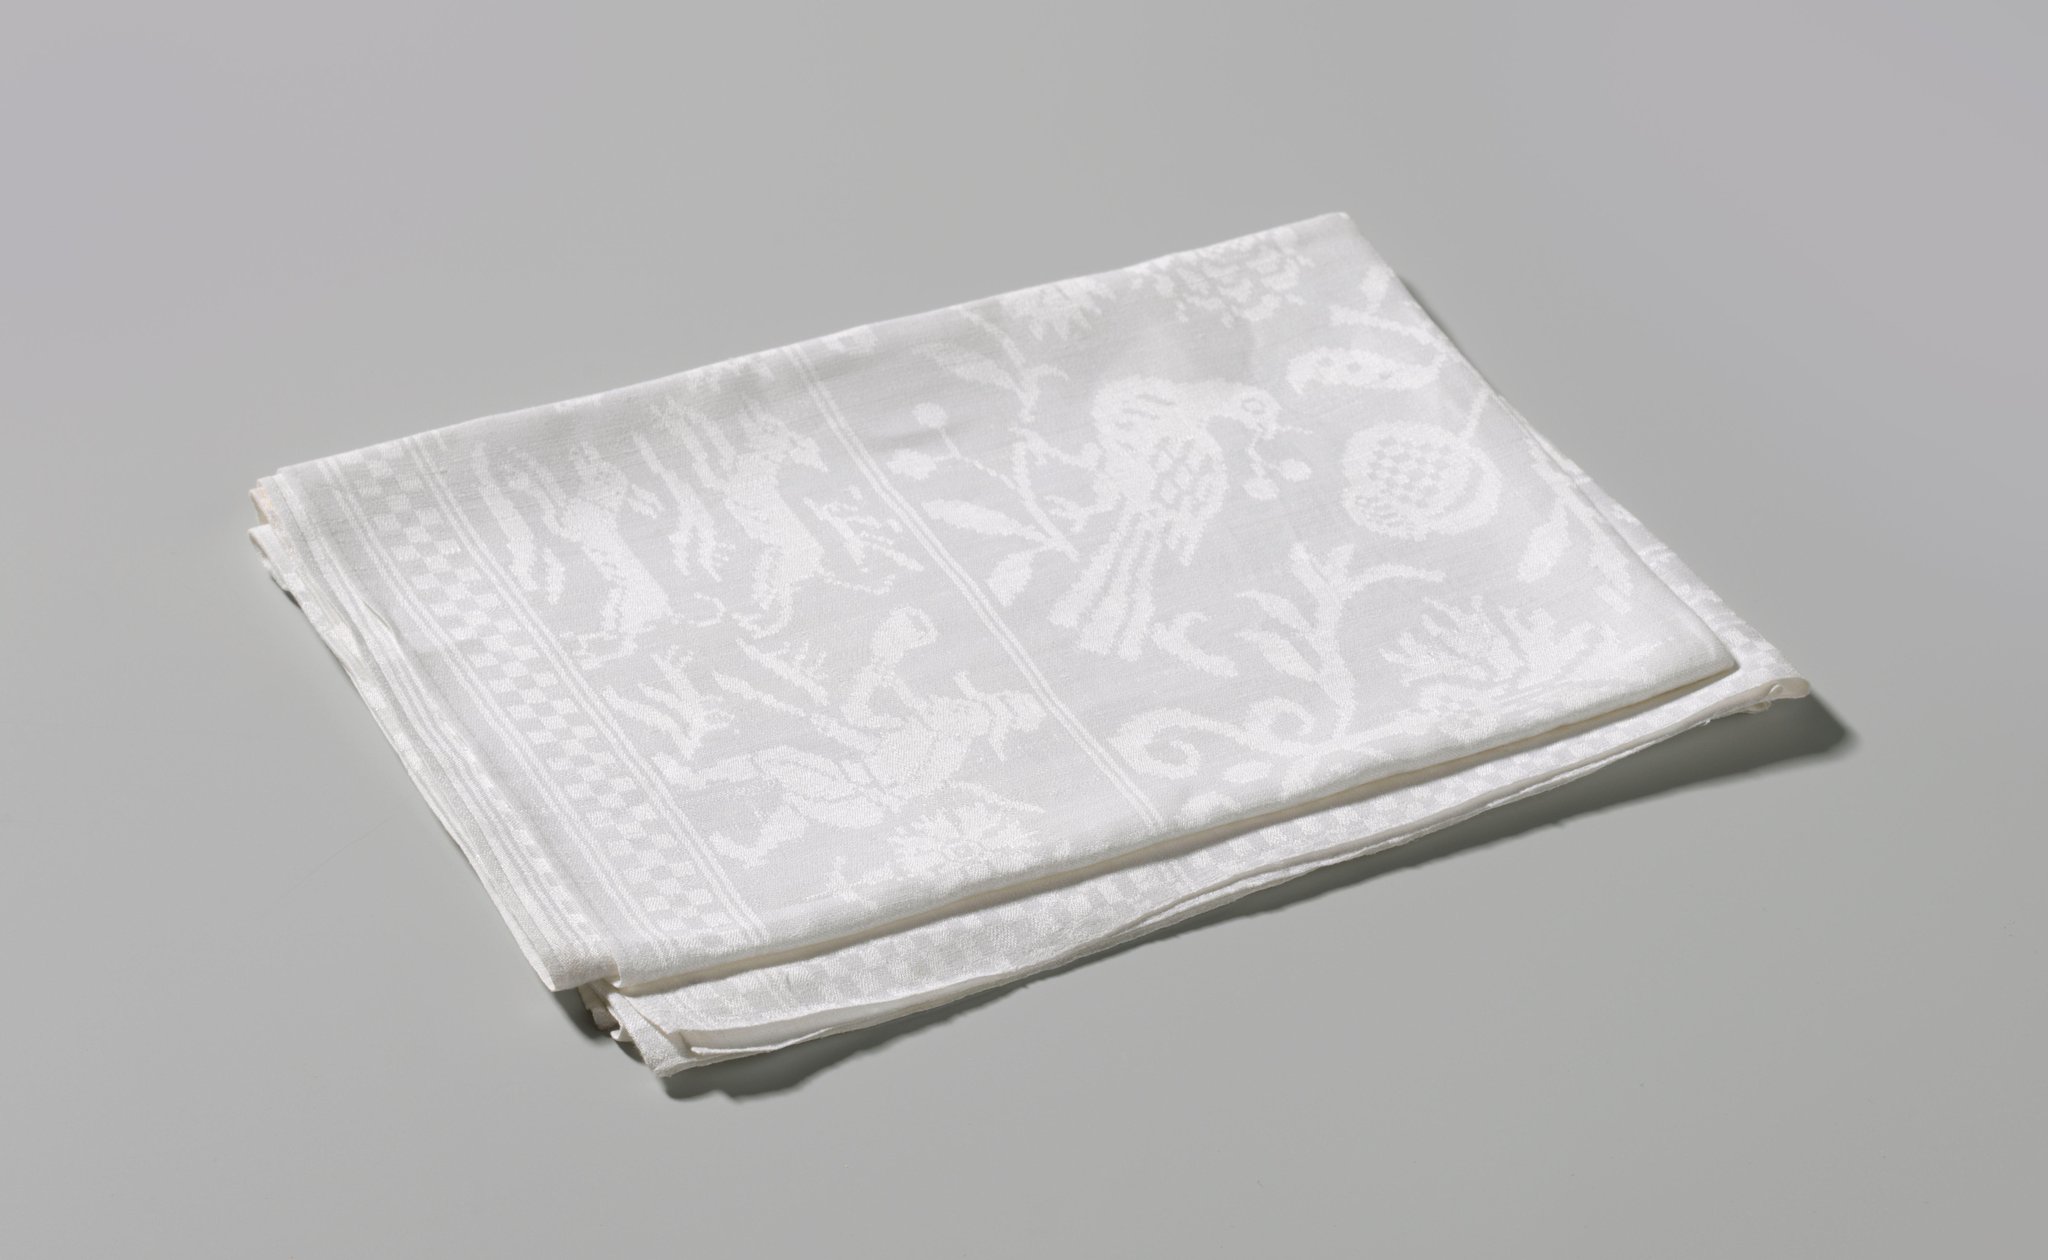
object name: napkin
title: Servet met gestrooide bloemen, vruchten en vogels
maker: Anonymous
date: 1651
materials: linen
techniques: damask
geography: netherlands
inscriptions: date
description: Servet van wit linnendamast met gestooide bloemen en vruchten met vogels.